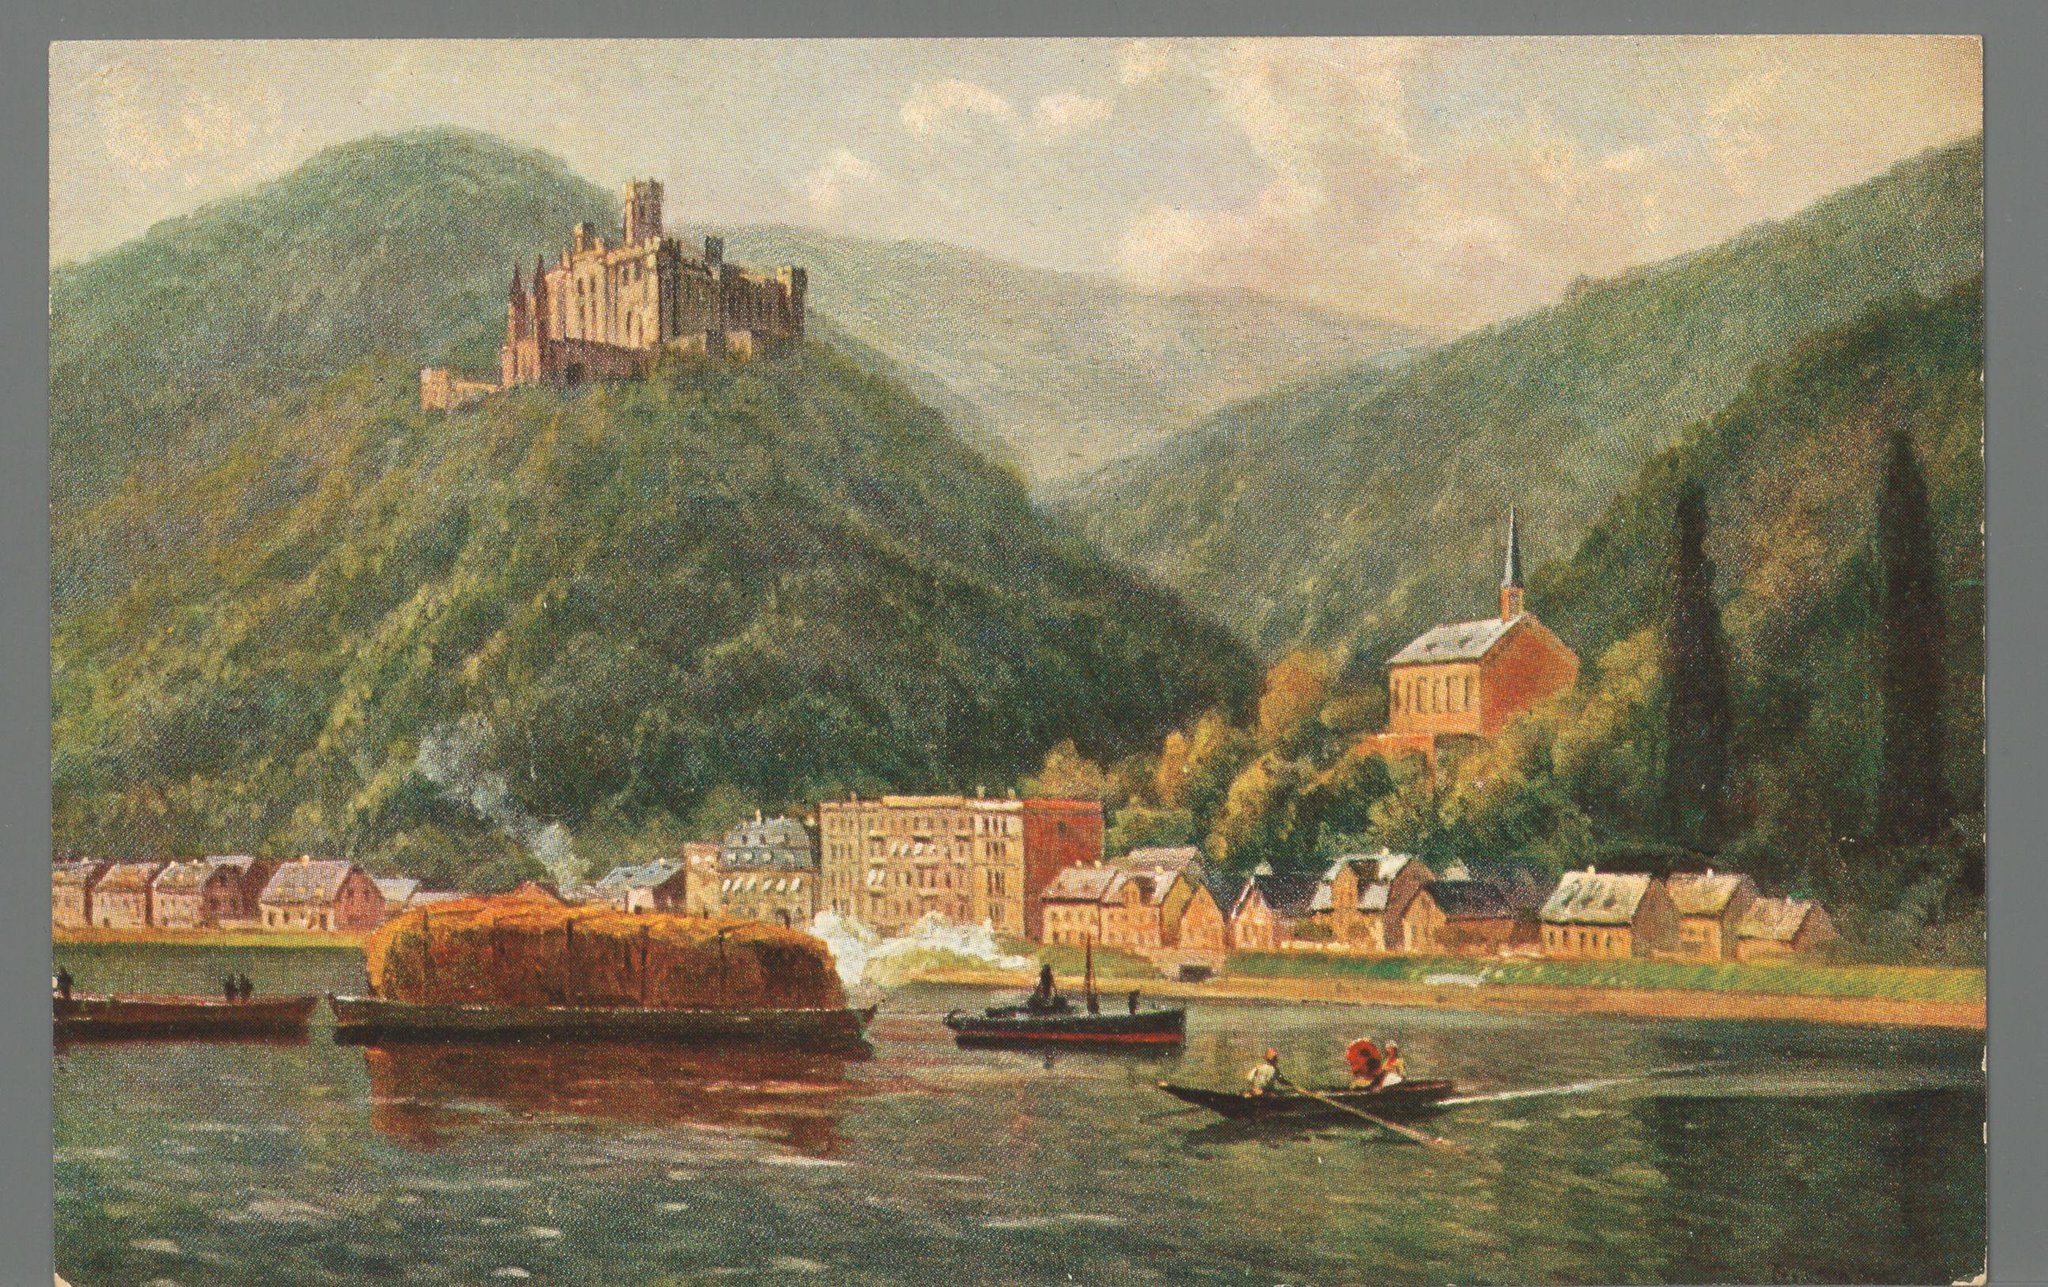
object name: reproduction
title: T.S.N. Serie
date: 1905-1930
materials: cardboard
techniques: color autotype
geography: nuremberg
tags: castle, river